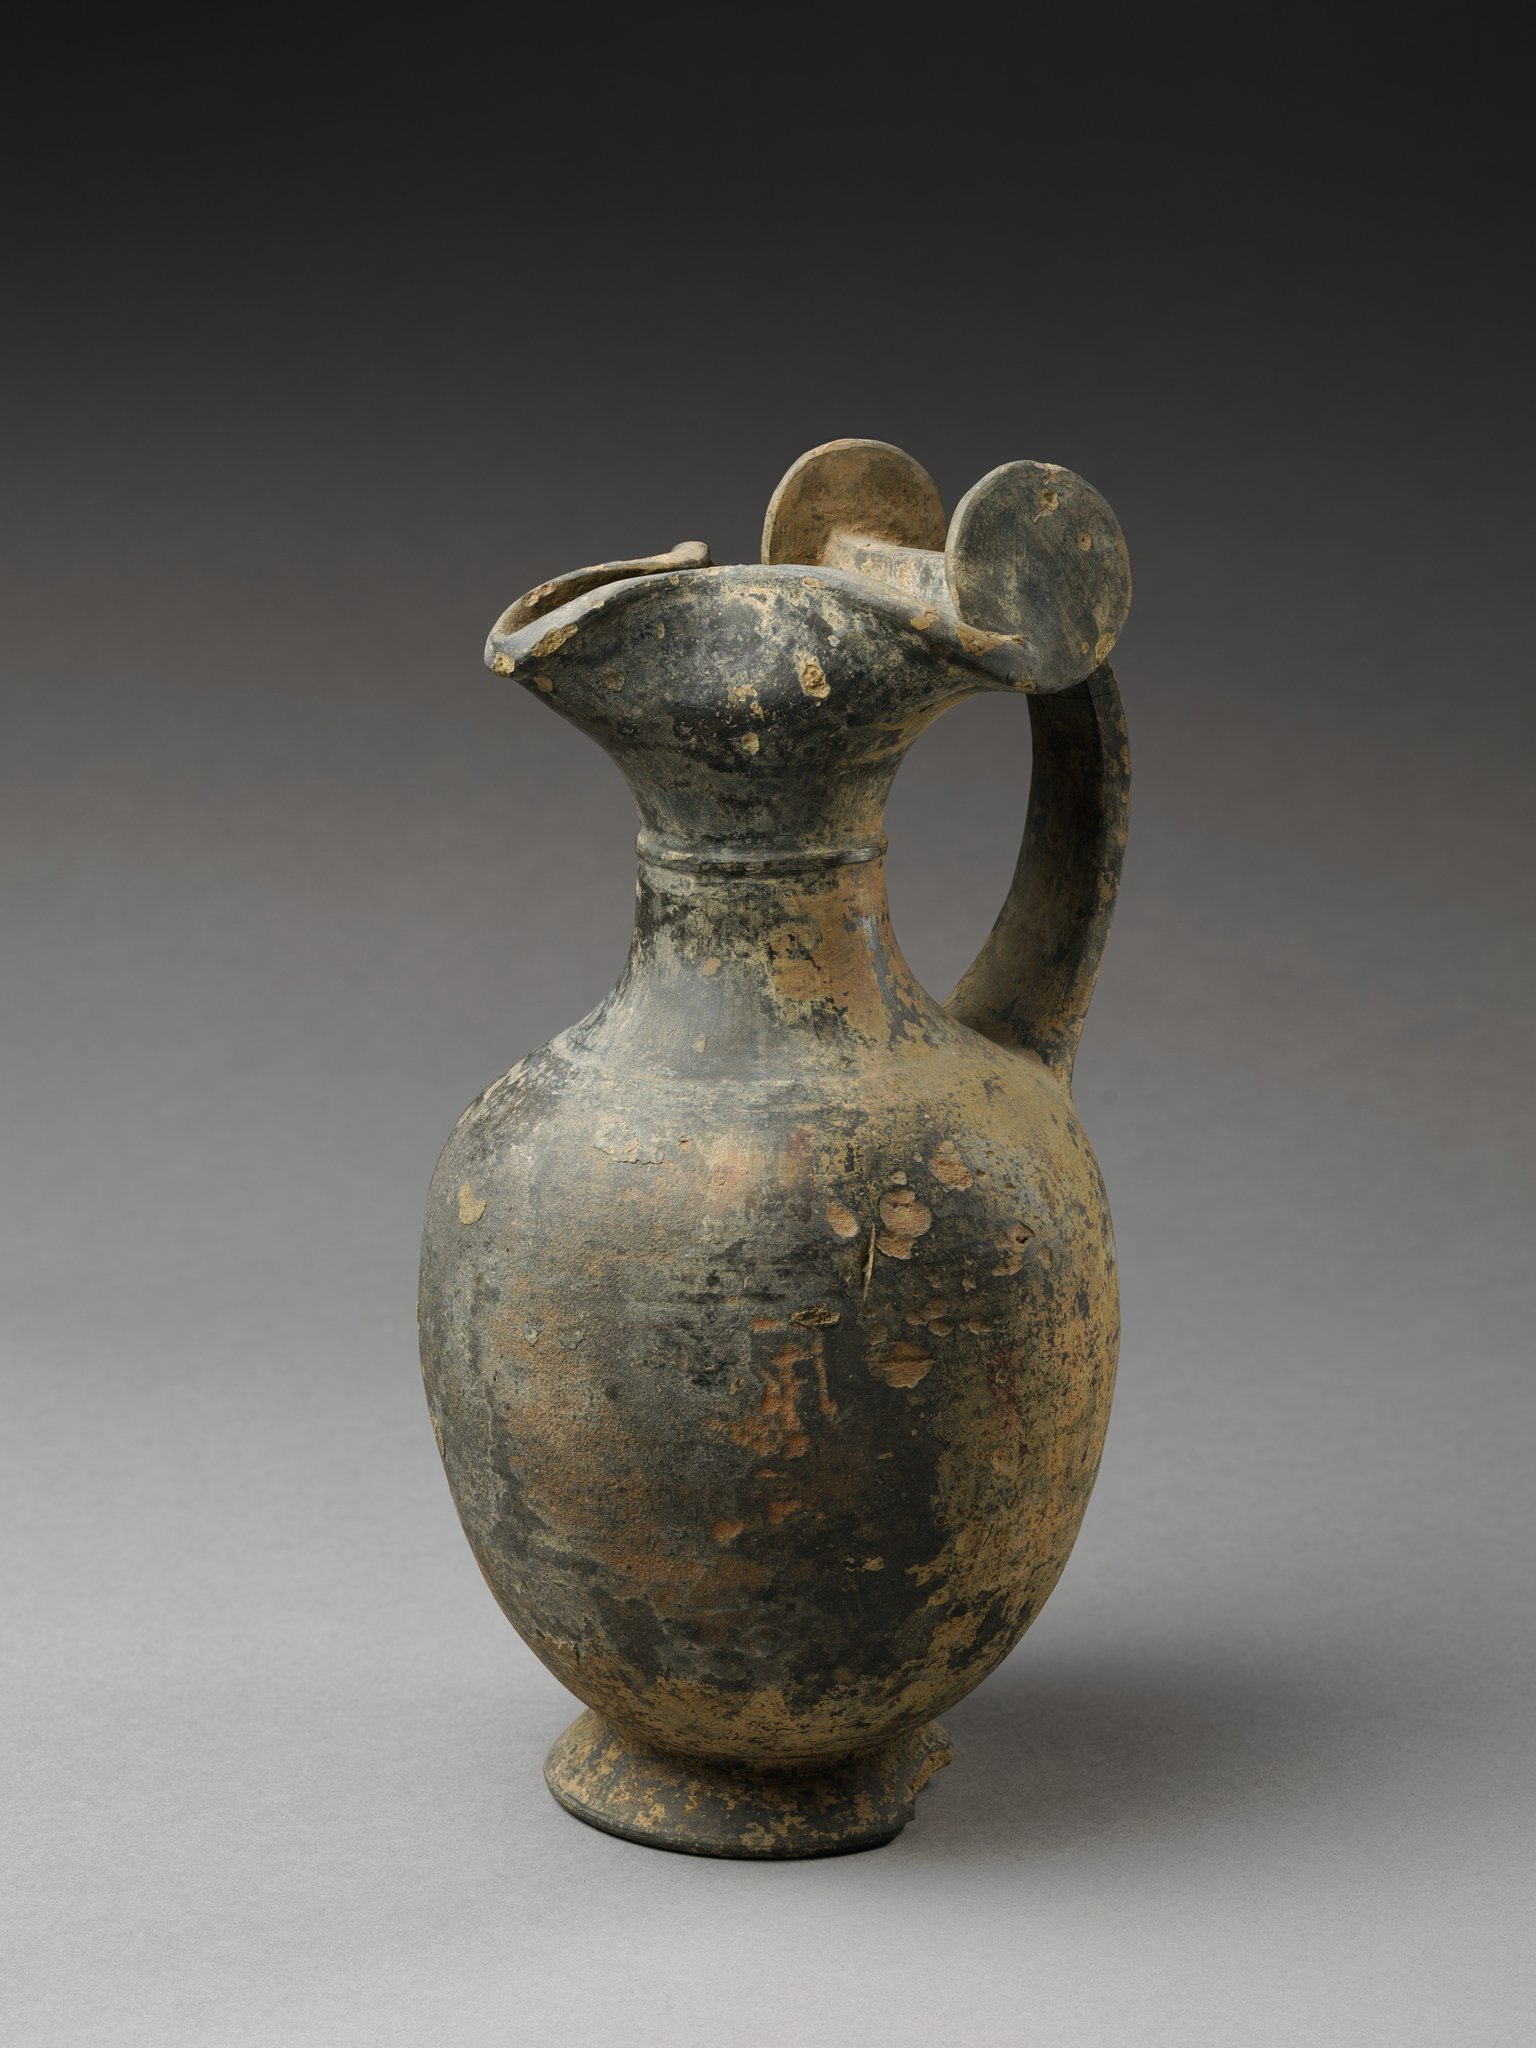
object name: oinochoe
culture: etruscan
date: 700-501 BCE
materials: terracotta